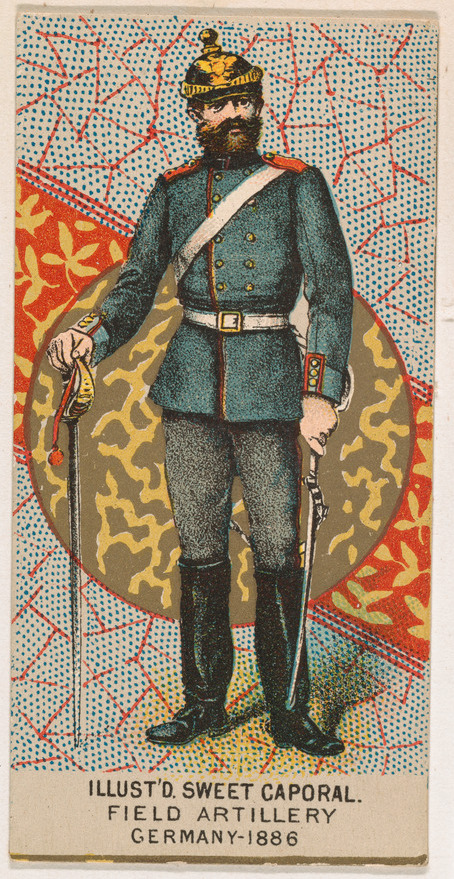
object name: print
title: Field Artillery, Germany, 1886, from the Military Series (N224) issued by Kinney Tobacco Company to promote Sweet Caporal Cigarettes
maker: kinney brothers tobacco company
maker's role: publisher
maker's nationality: american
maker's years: 1869-2011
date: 1888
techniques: color lithograph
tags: military,men